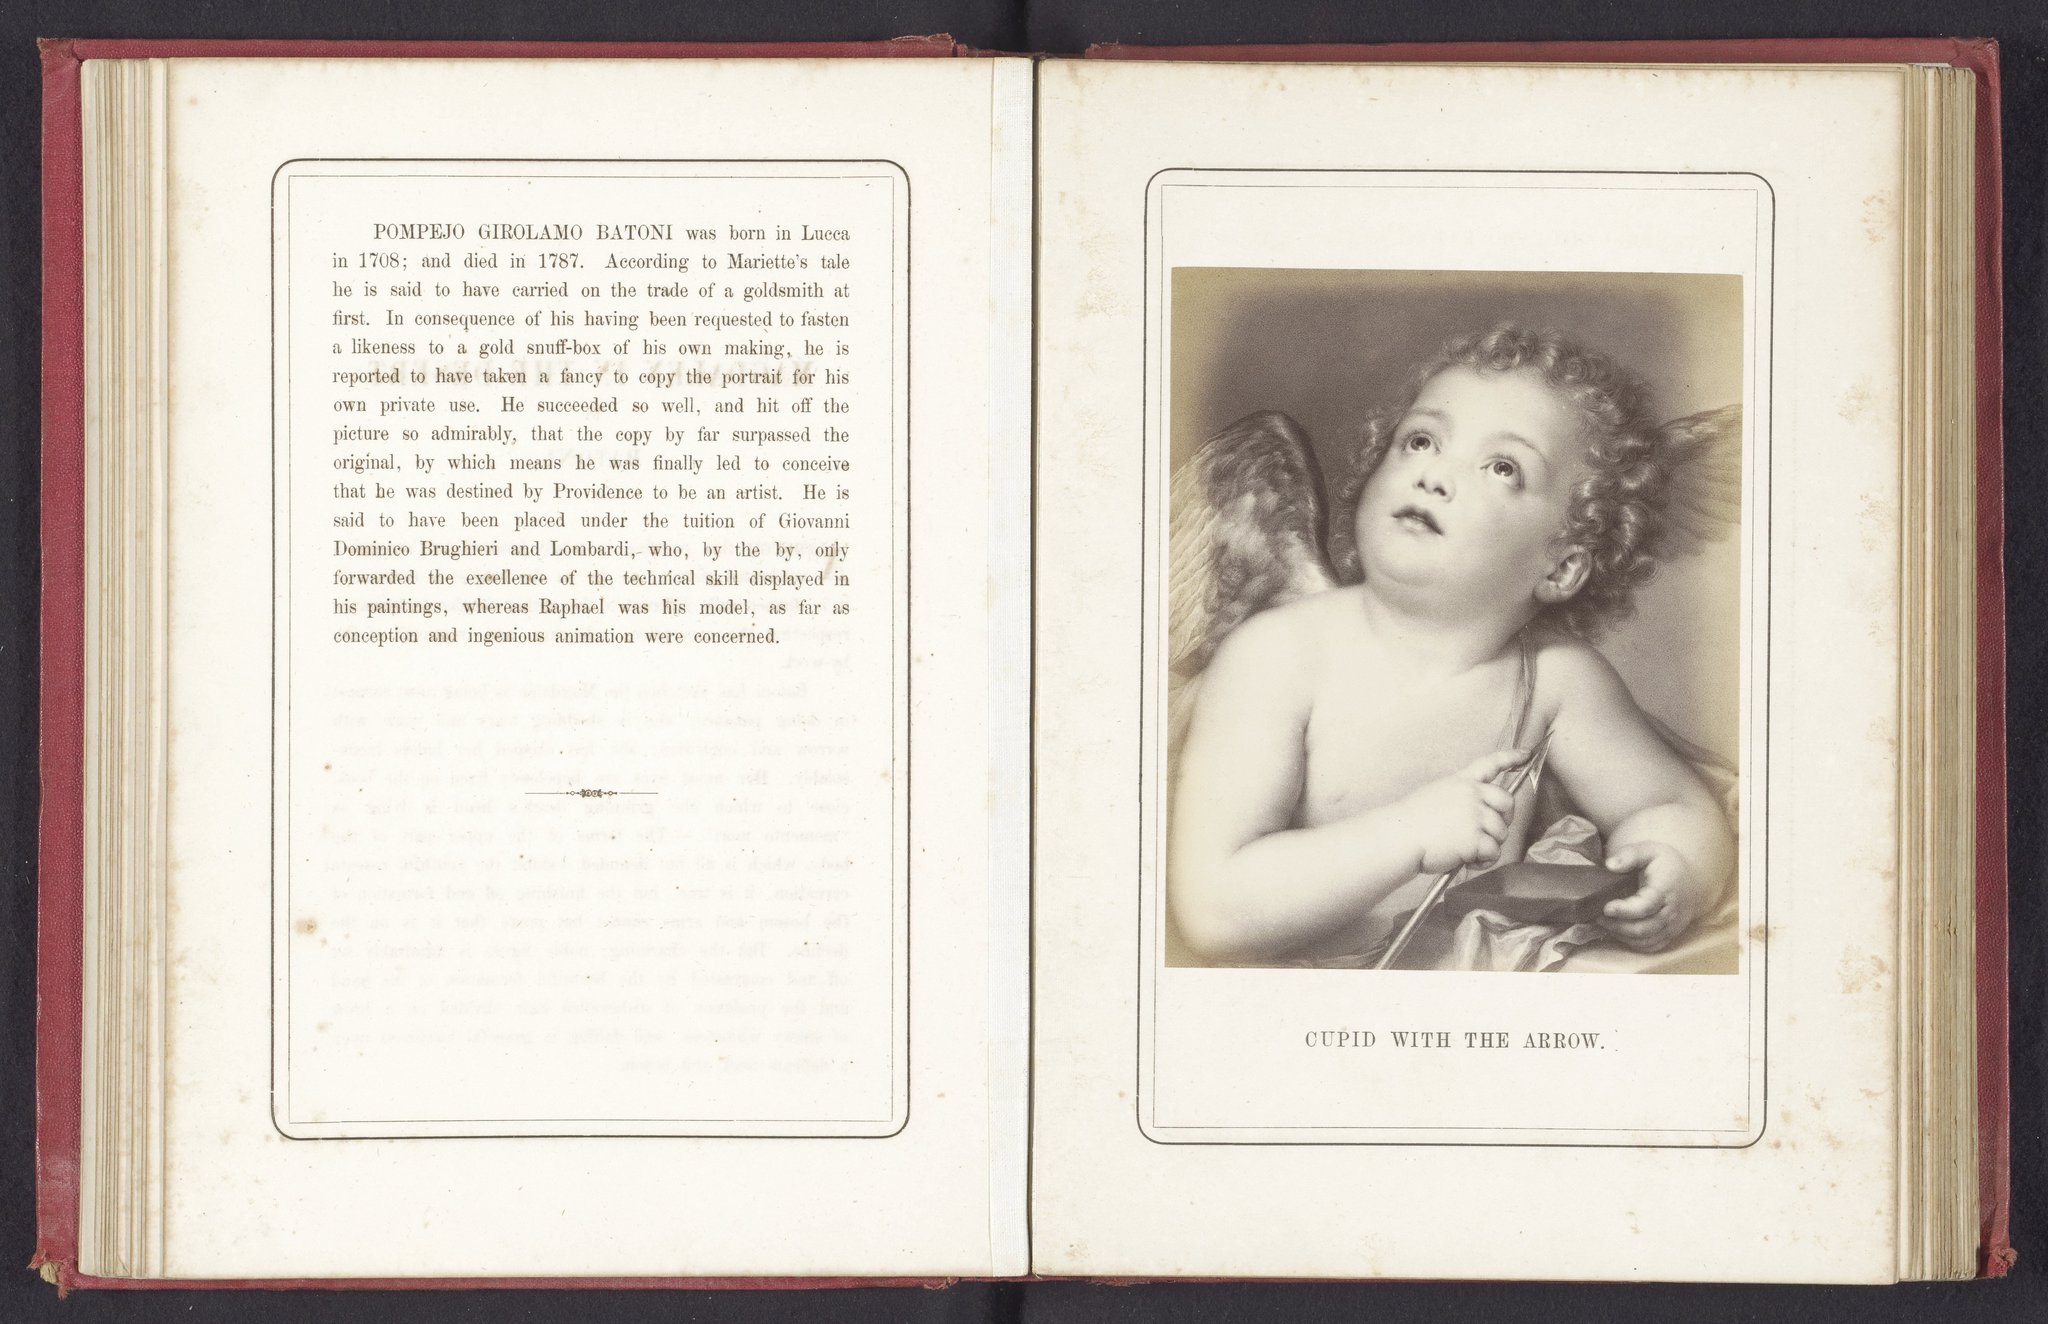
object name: page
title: Cupid with the arrow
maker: hanns hanfstaengl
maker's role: print maker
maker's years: 1820-1885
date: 1854-1864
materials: photographic support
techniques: albumen print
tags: picture, painting, cupids: 'amores', 'amoretti', 'putti'